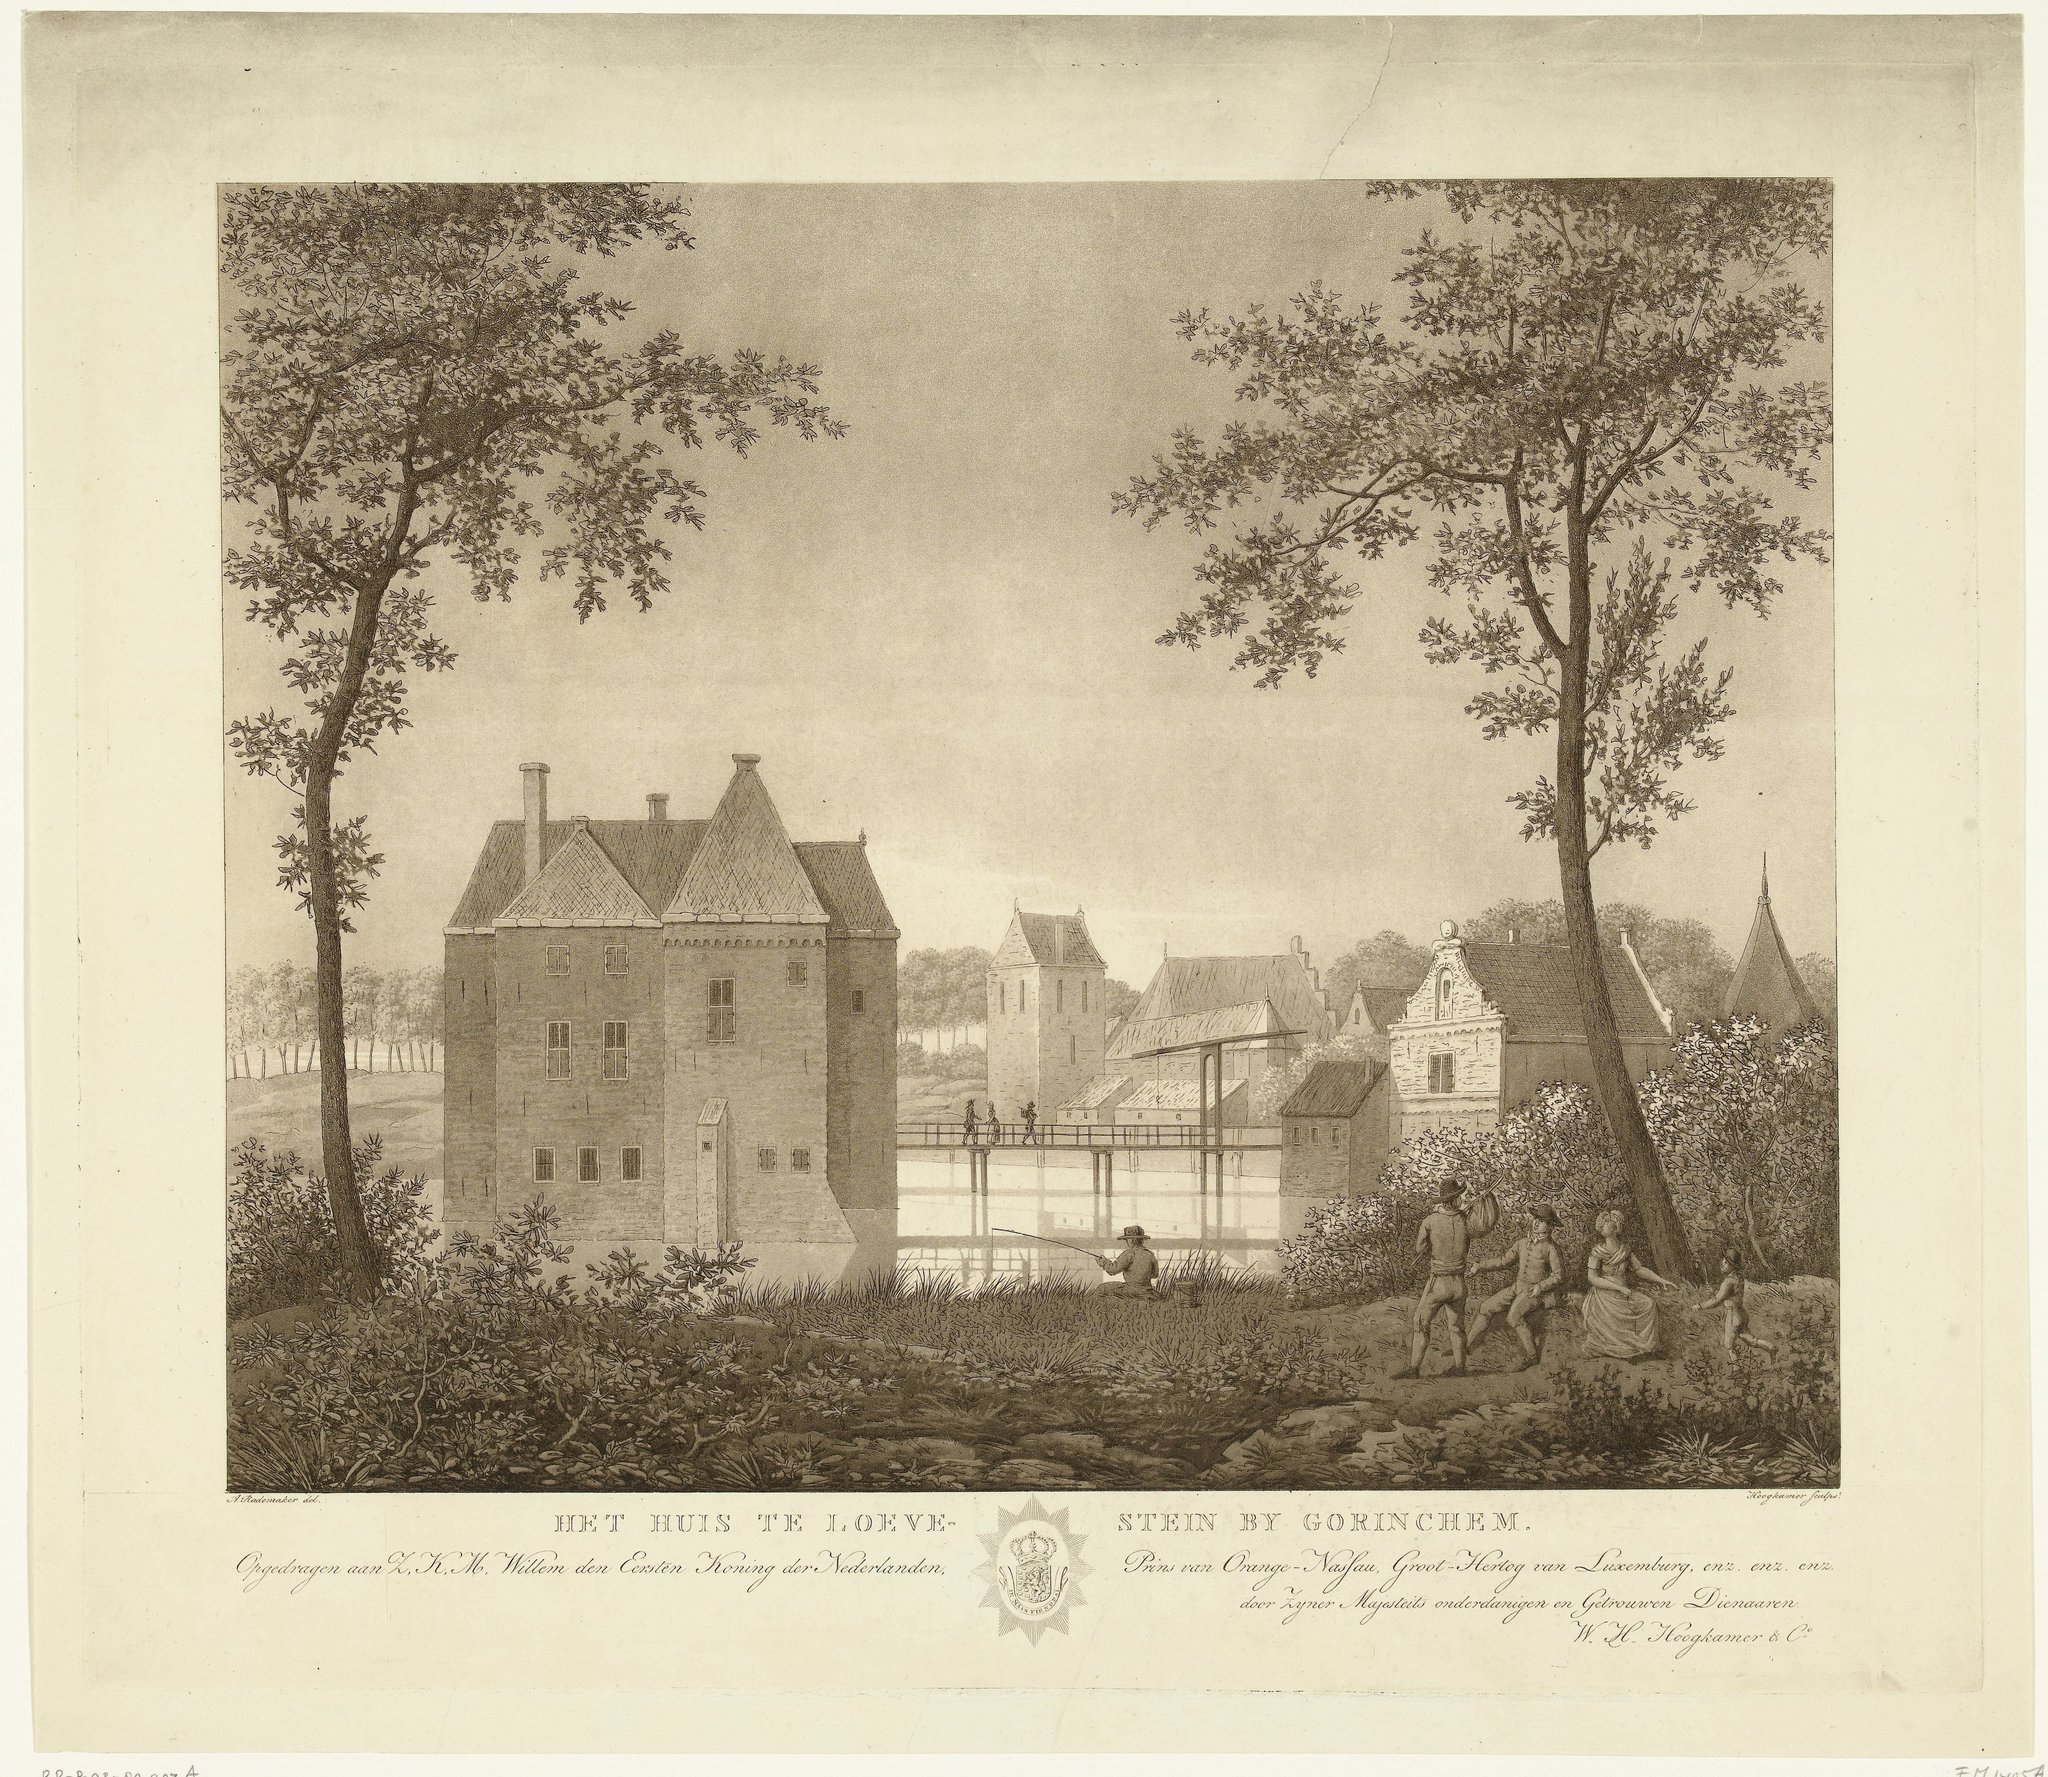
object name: print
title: Slot Loevestein, ca. 1820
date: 1814-1864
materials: paper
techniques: aquatint, etching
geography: netherlands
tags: delft, hugo de groot, hoorn (north holland), castle, loevestein castle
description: Gezicht op het slot Loevestein waar Rombout Hogerbeets en Hugo de Groot, beiden op 18 mei 1619 tot levenslange opsluiting op het kasteel veroordeeld, in gevangenschap verkeerden. Gezicht op het kasteel zoals het zich ca. 1820 vertoonde. Op de voorgrond bezoekers en een hengelaar. Bij de plaat behoort een gedrukte beschrijving.